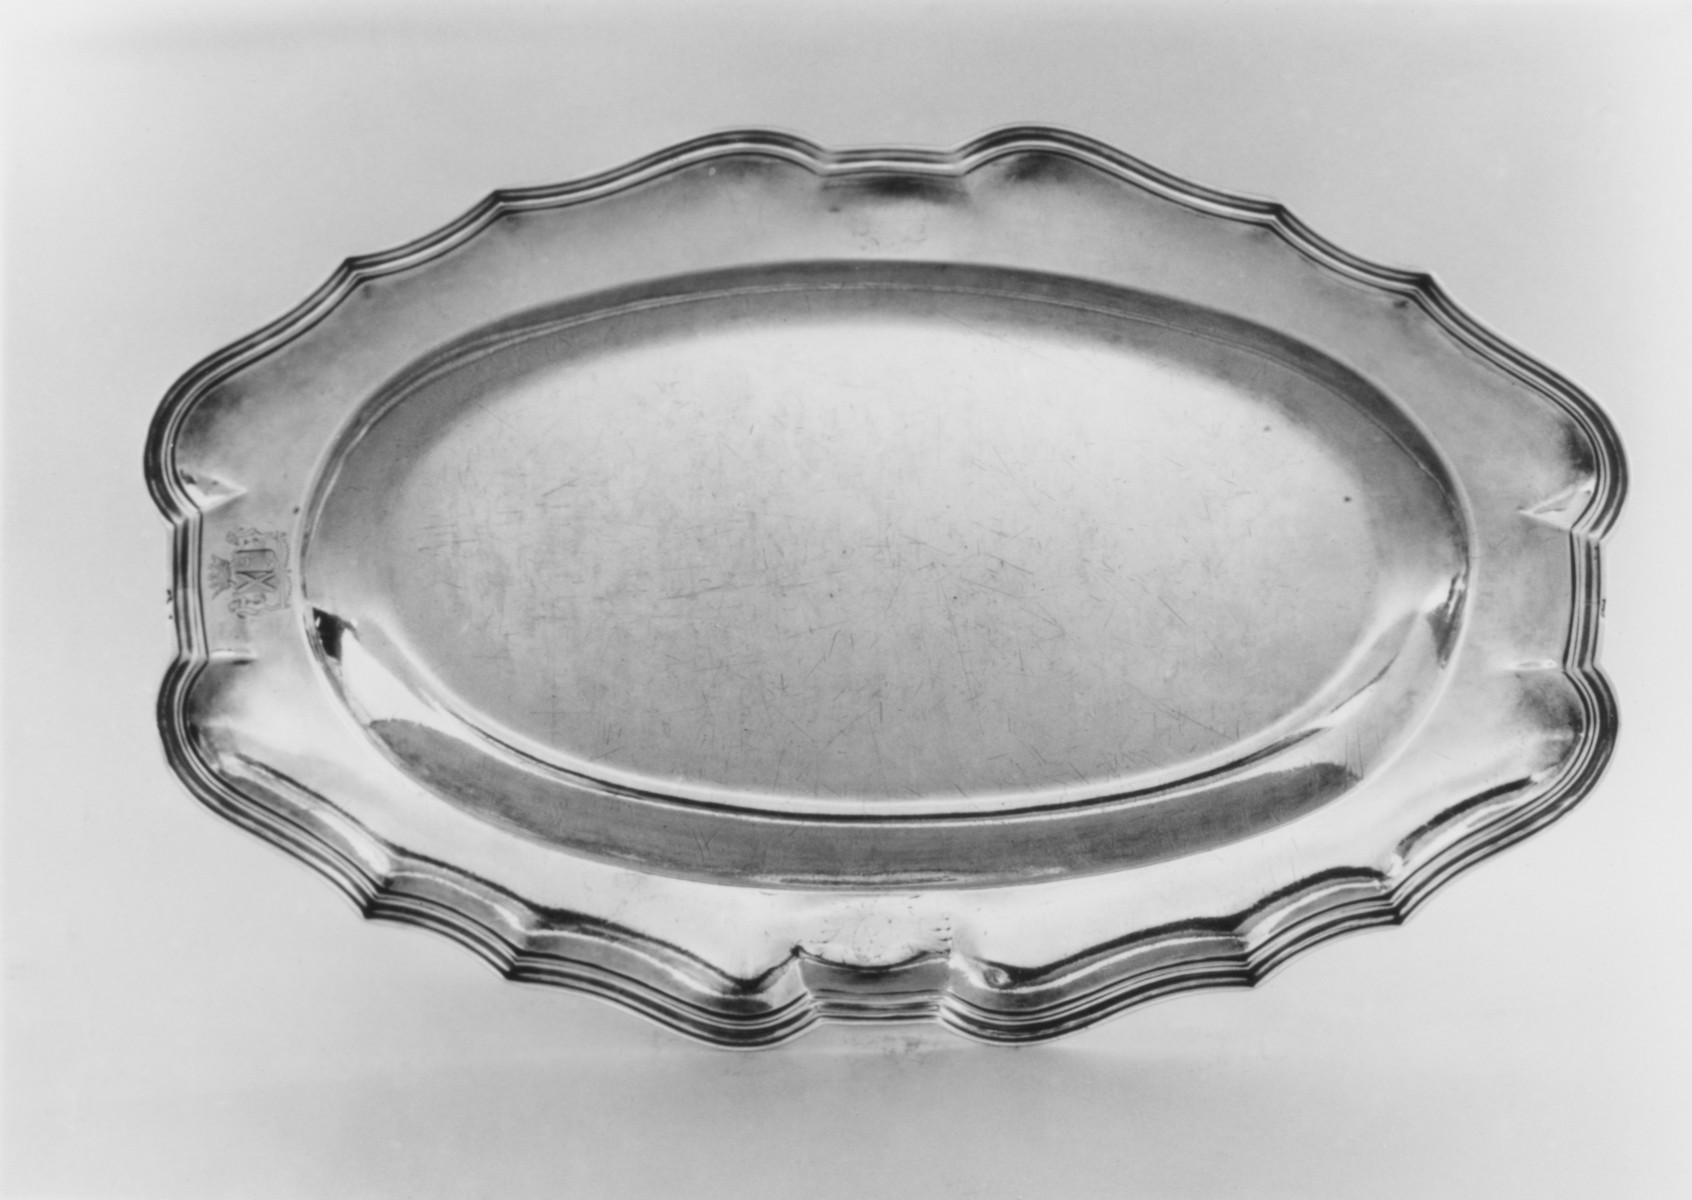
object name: dish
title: Oval dish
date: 1732-1733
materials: silver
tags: animals,coat of arms